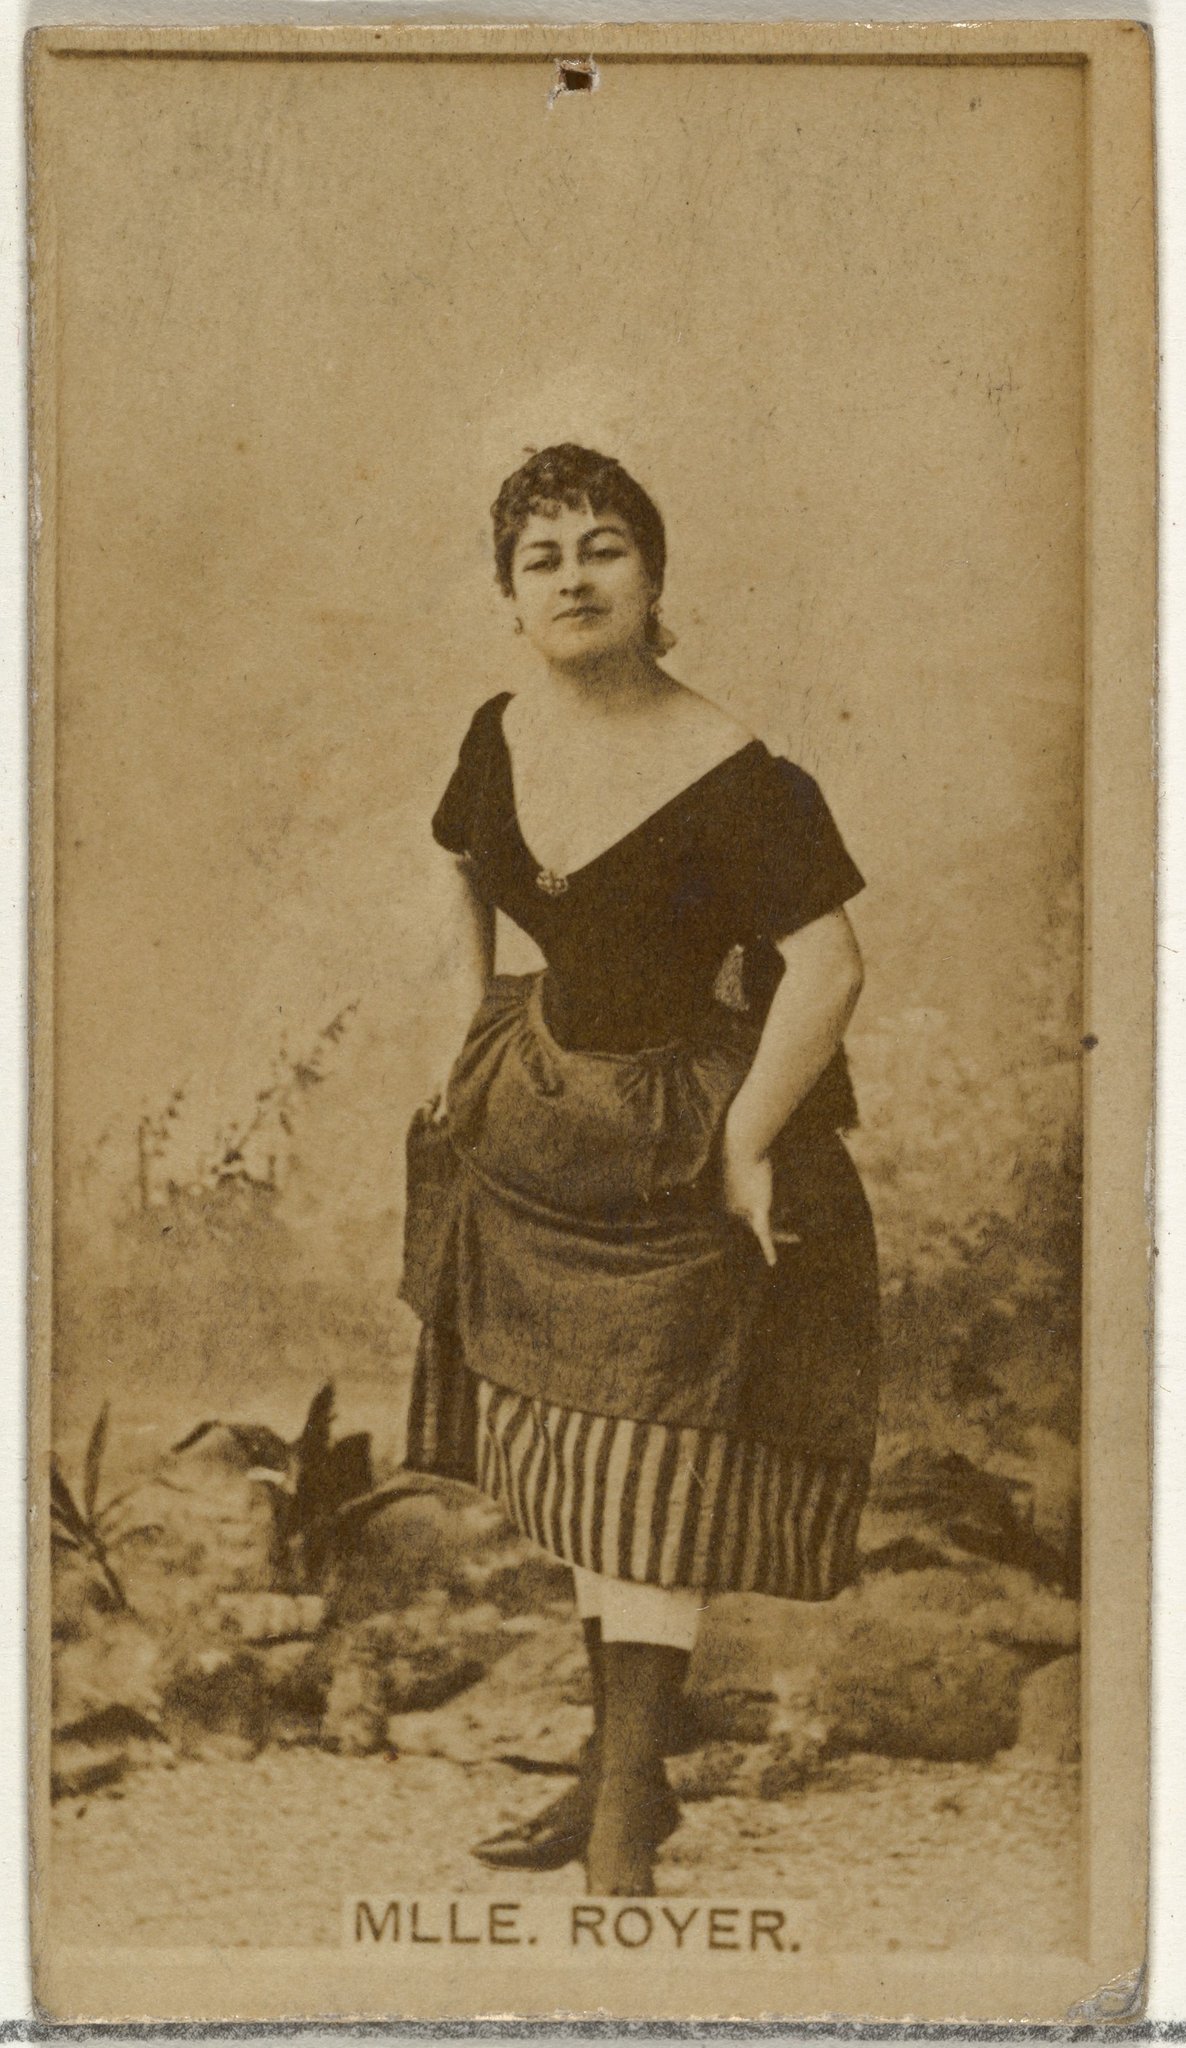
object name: photograph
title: Mlle. Royer, from the Actors and Actresses series (N145-8) issued by Duke Sons & Co. to promote Duke Cigarettes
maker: w. duke, sons & co.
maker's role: publisher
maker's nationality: american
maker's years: 1870-1920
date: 1891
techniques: albumen silver print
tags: portraits,women,actresses